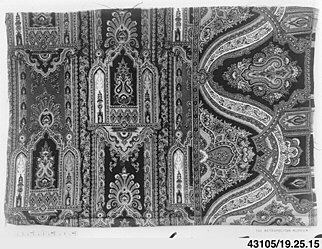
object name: sample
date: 1830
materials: wool